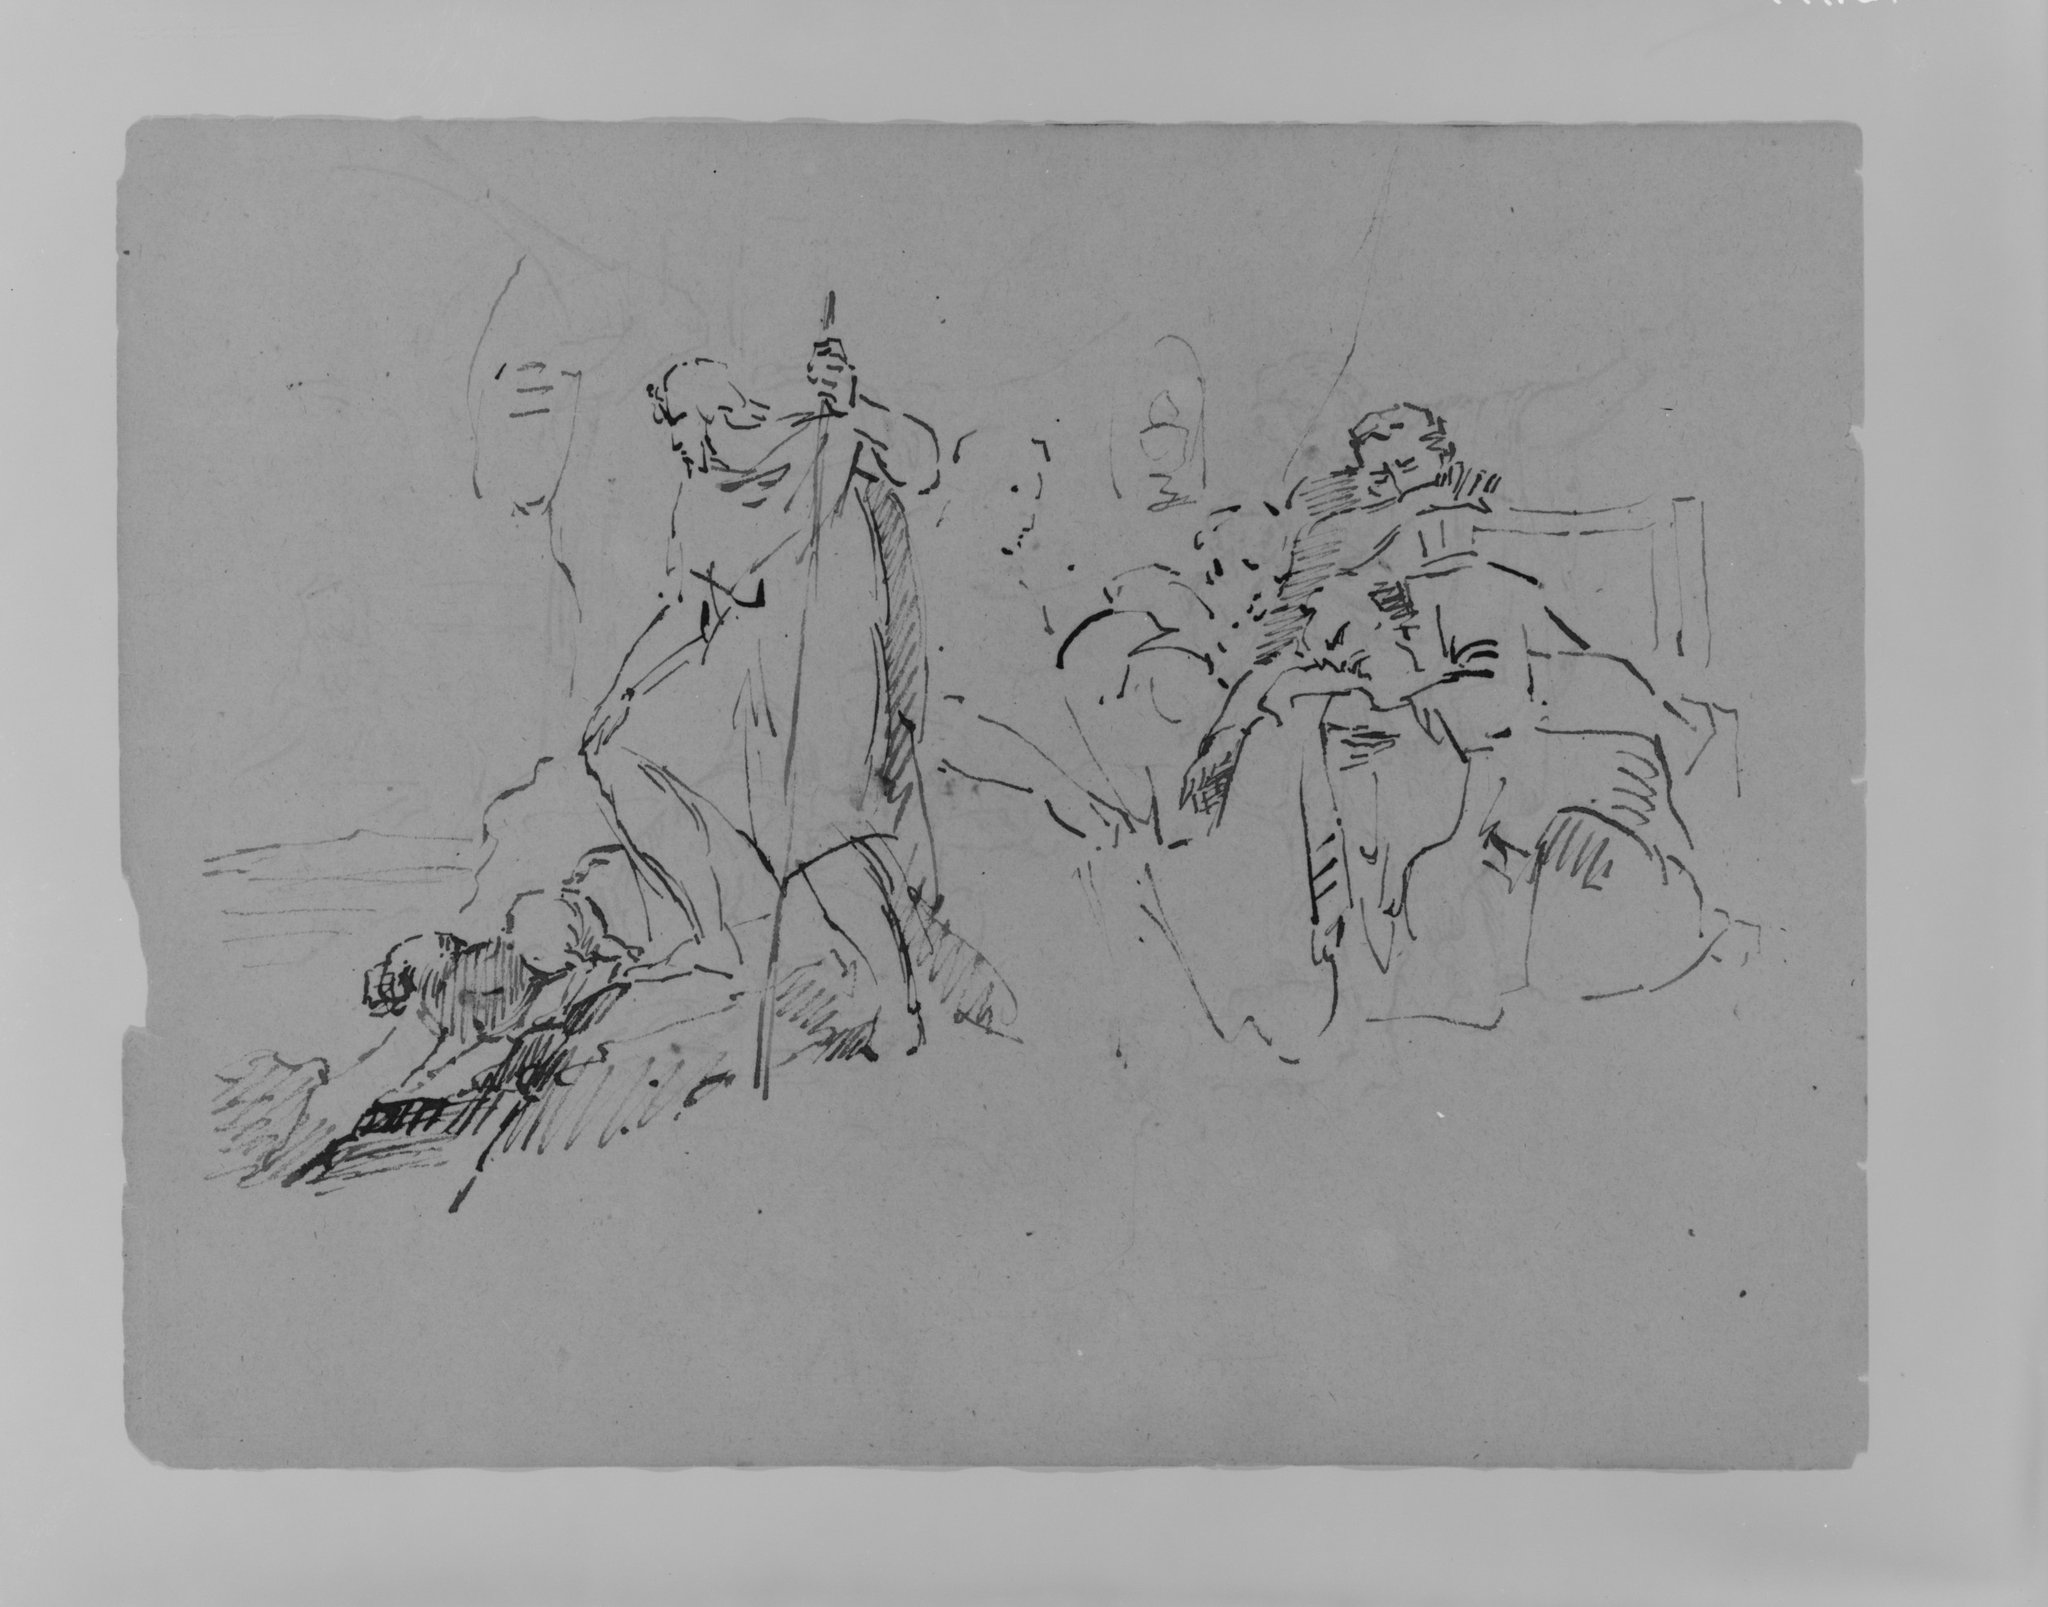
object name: drawing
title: Man and Dog Overlooming Distant Landscape; Seated Man Collapsing, Attended by Three Figures (from Sketchbook)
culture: american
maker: thomas sully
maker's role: artist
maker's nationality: american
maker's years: 1783-1872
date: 1810-1820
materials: graphite, paper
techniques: wash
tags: men,dogs